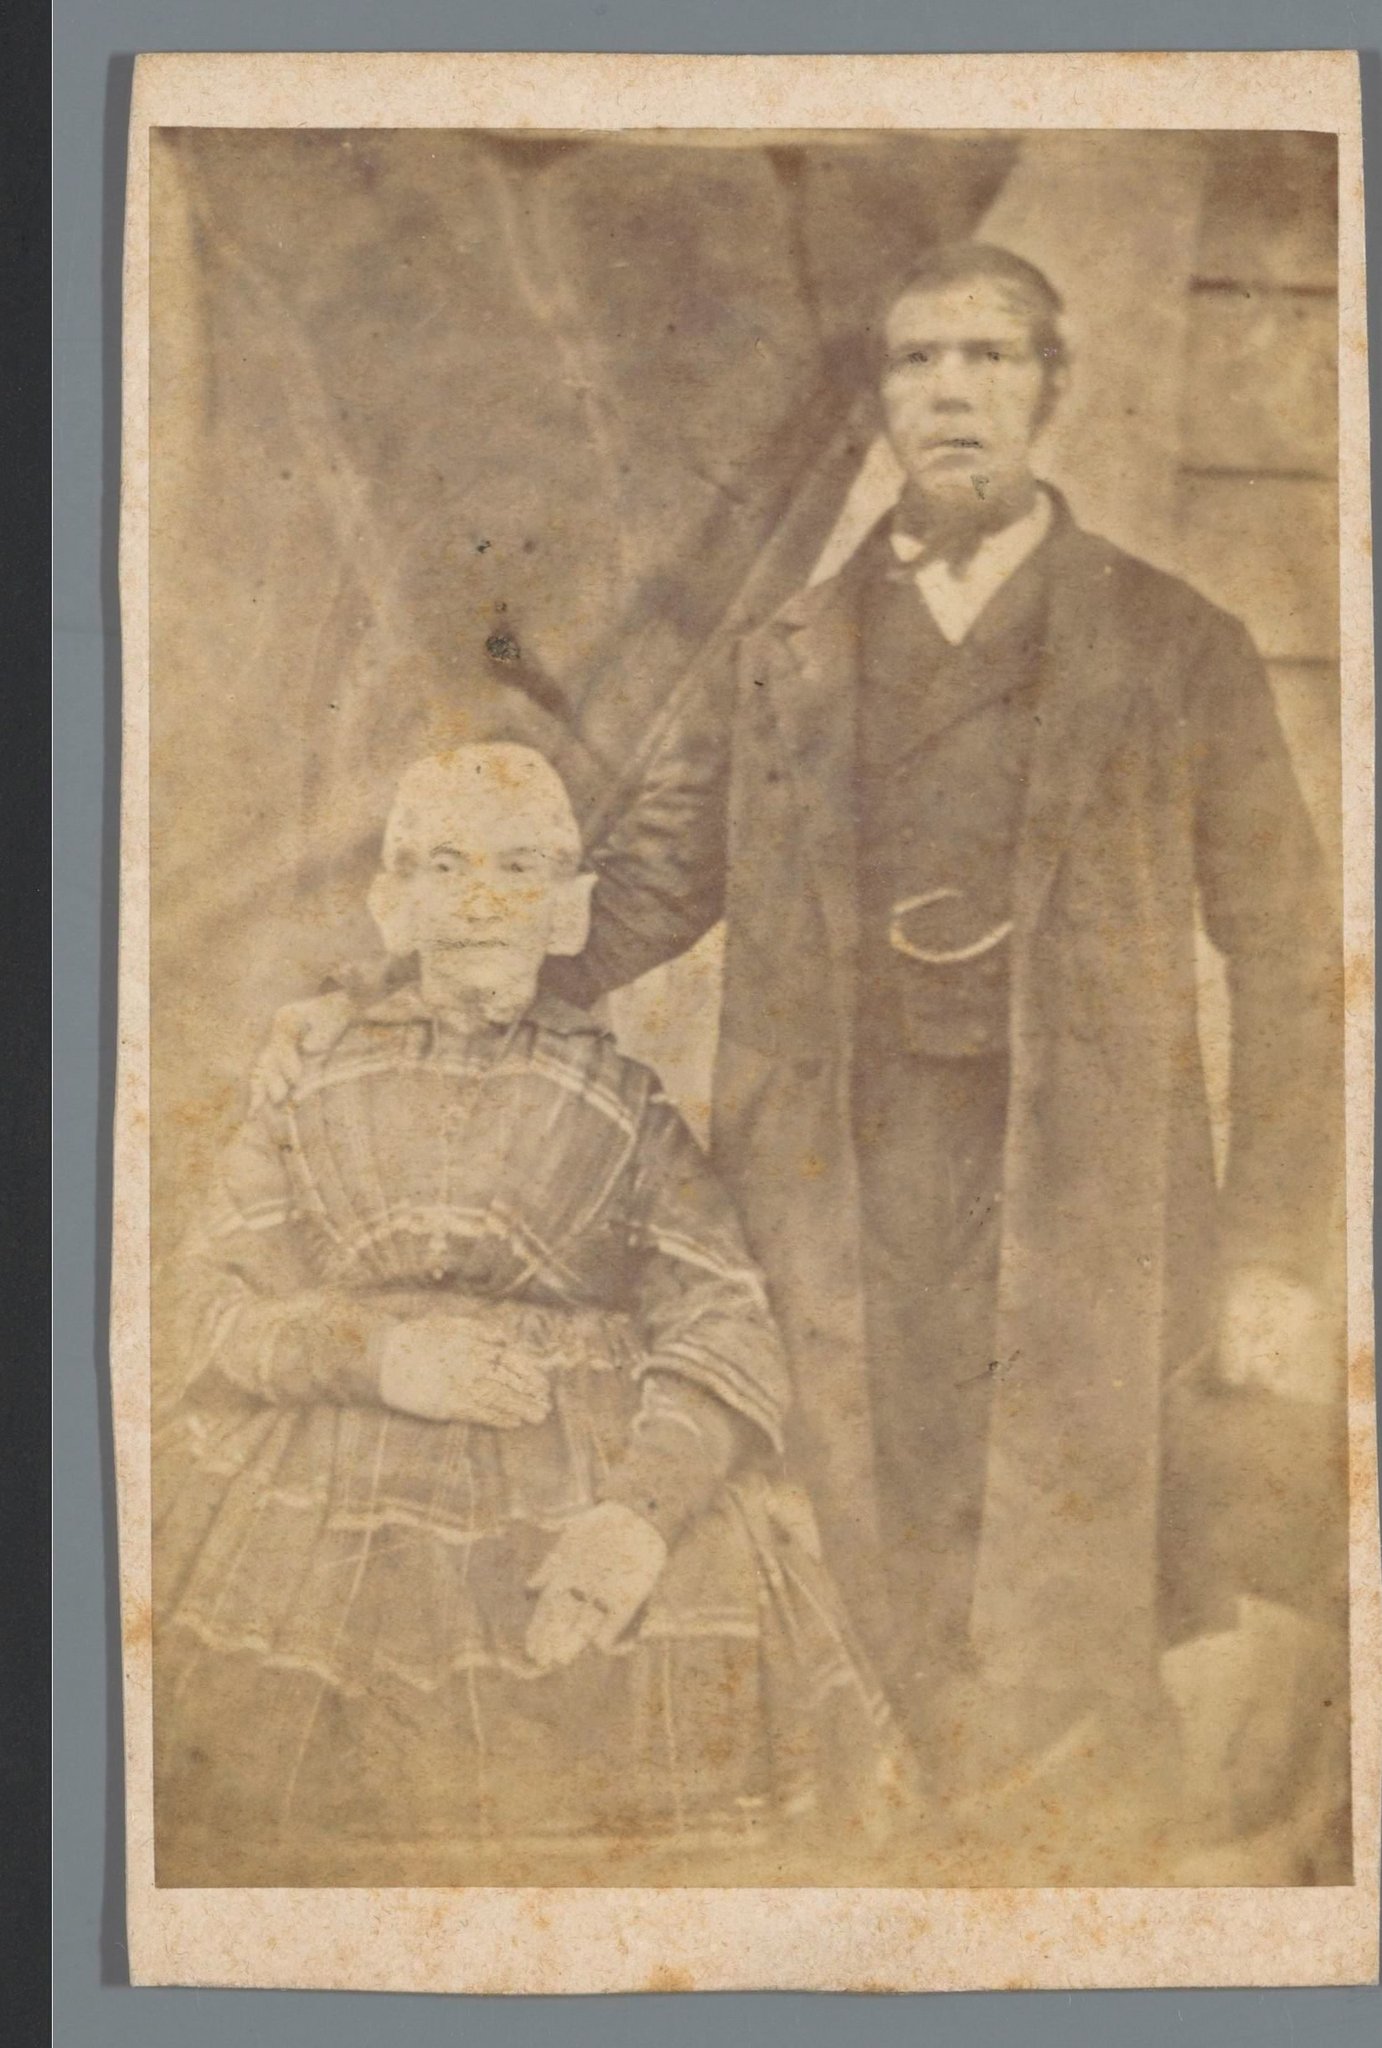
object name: photograph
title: Portret van een onbekende man en een onbekende vrouw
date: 1868-1870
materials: cardboard, paper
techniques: albumen print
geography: amsterdam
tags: adult woman, adult man, historical persons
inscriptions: inscription: ‘12’, inscription: ‘Photogaphisch Etablissement/ VAN/ C. Stapert & van Caspel./ Bloemgracht D.D.43./ AMSTERDAM.’